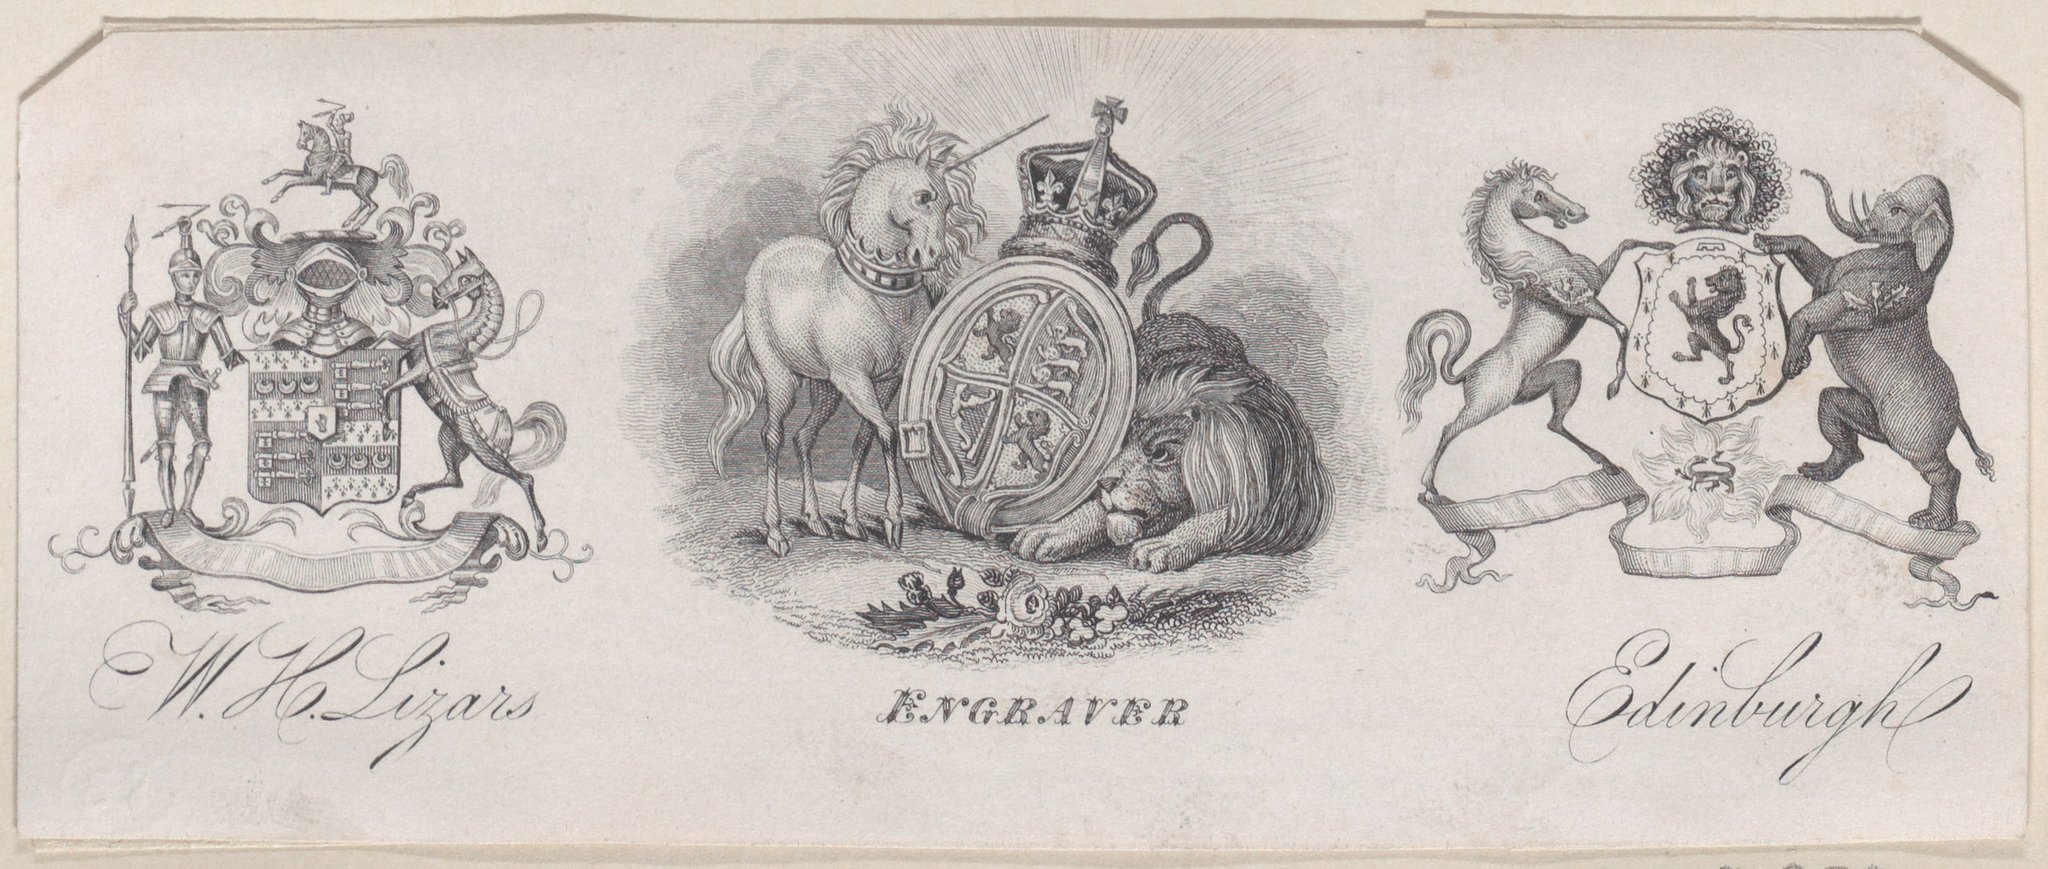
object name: print, trade card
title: Trade Card for W. H. Lizars, Engraver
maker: anonymous, british, late 18th–early 19th century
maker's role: artist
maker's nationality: british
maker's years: 1771-1835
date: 1701-1800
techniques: engraving